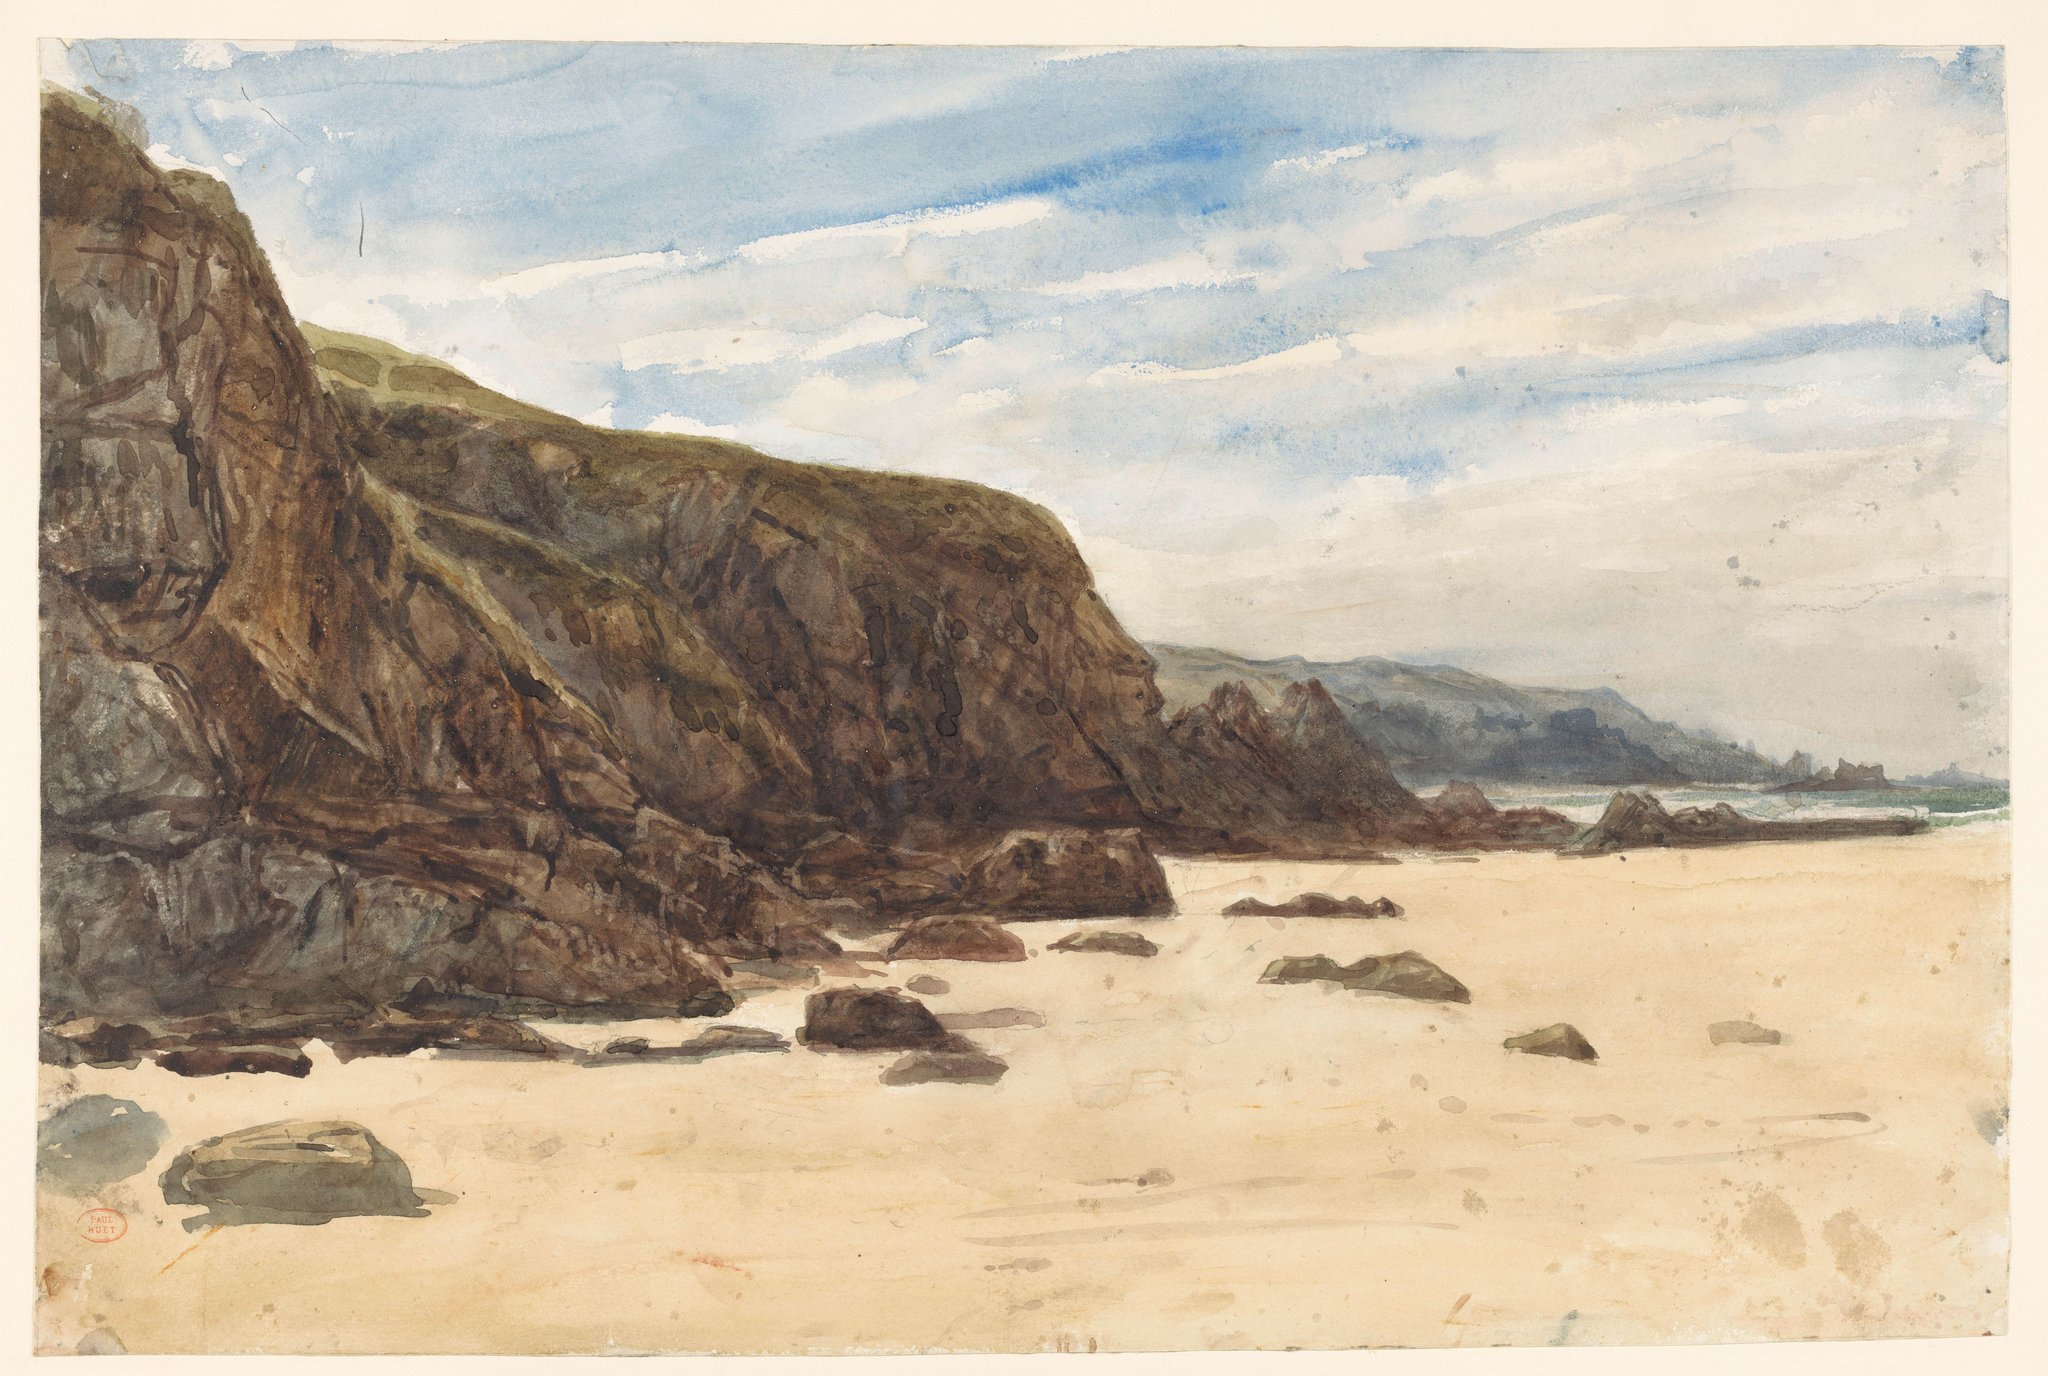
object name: drawing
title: Les Roches noirs, bij Villers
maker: paul huet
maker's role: draughtsman, print maker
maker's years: 1803-1869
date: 1813-1869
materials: paper, pencil, watercolor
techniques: brush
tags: coastal cliff or crag